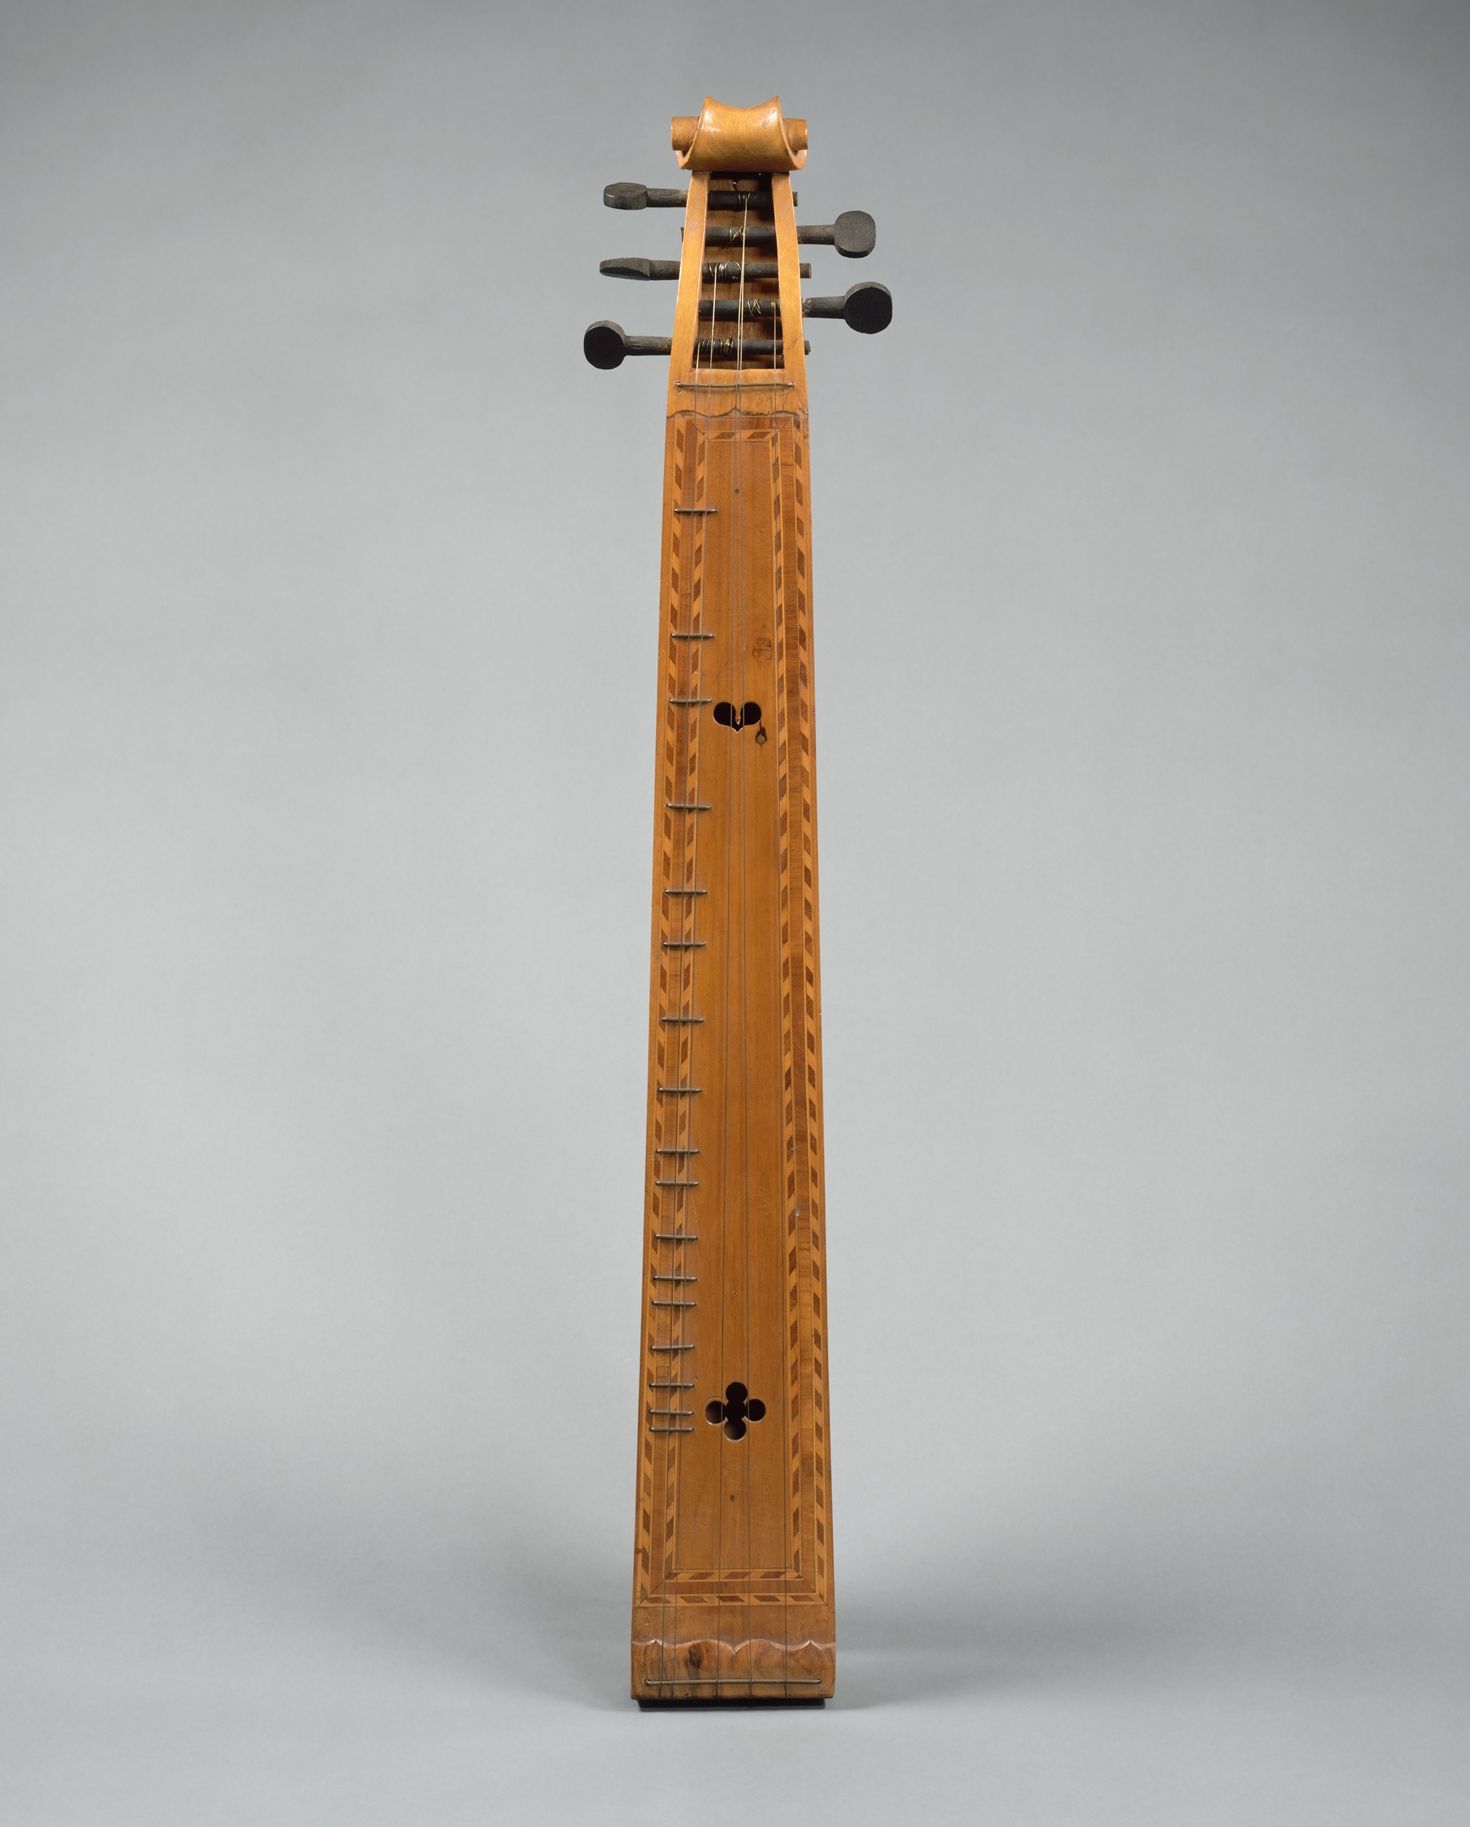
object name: épinette de vosges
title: Épinette des Vosges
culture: french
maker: amant constant (amé) lambert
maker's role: maker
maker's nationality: french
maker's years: 1843-1908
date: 1867-1900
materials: metal, wood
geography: france